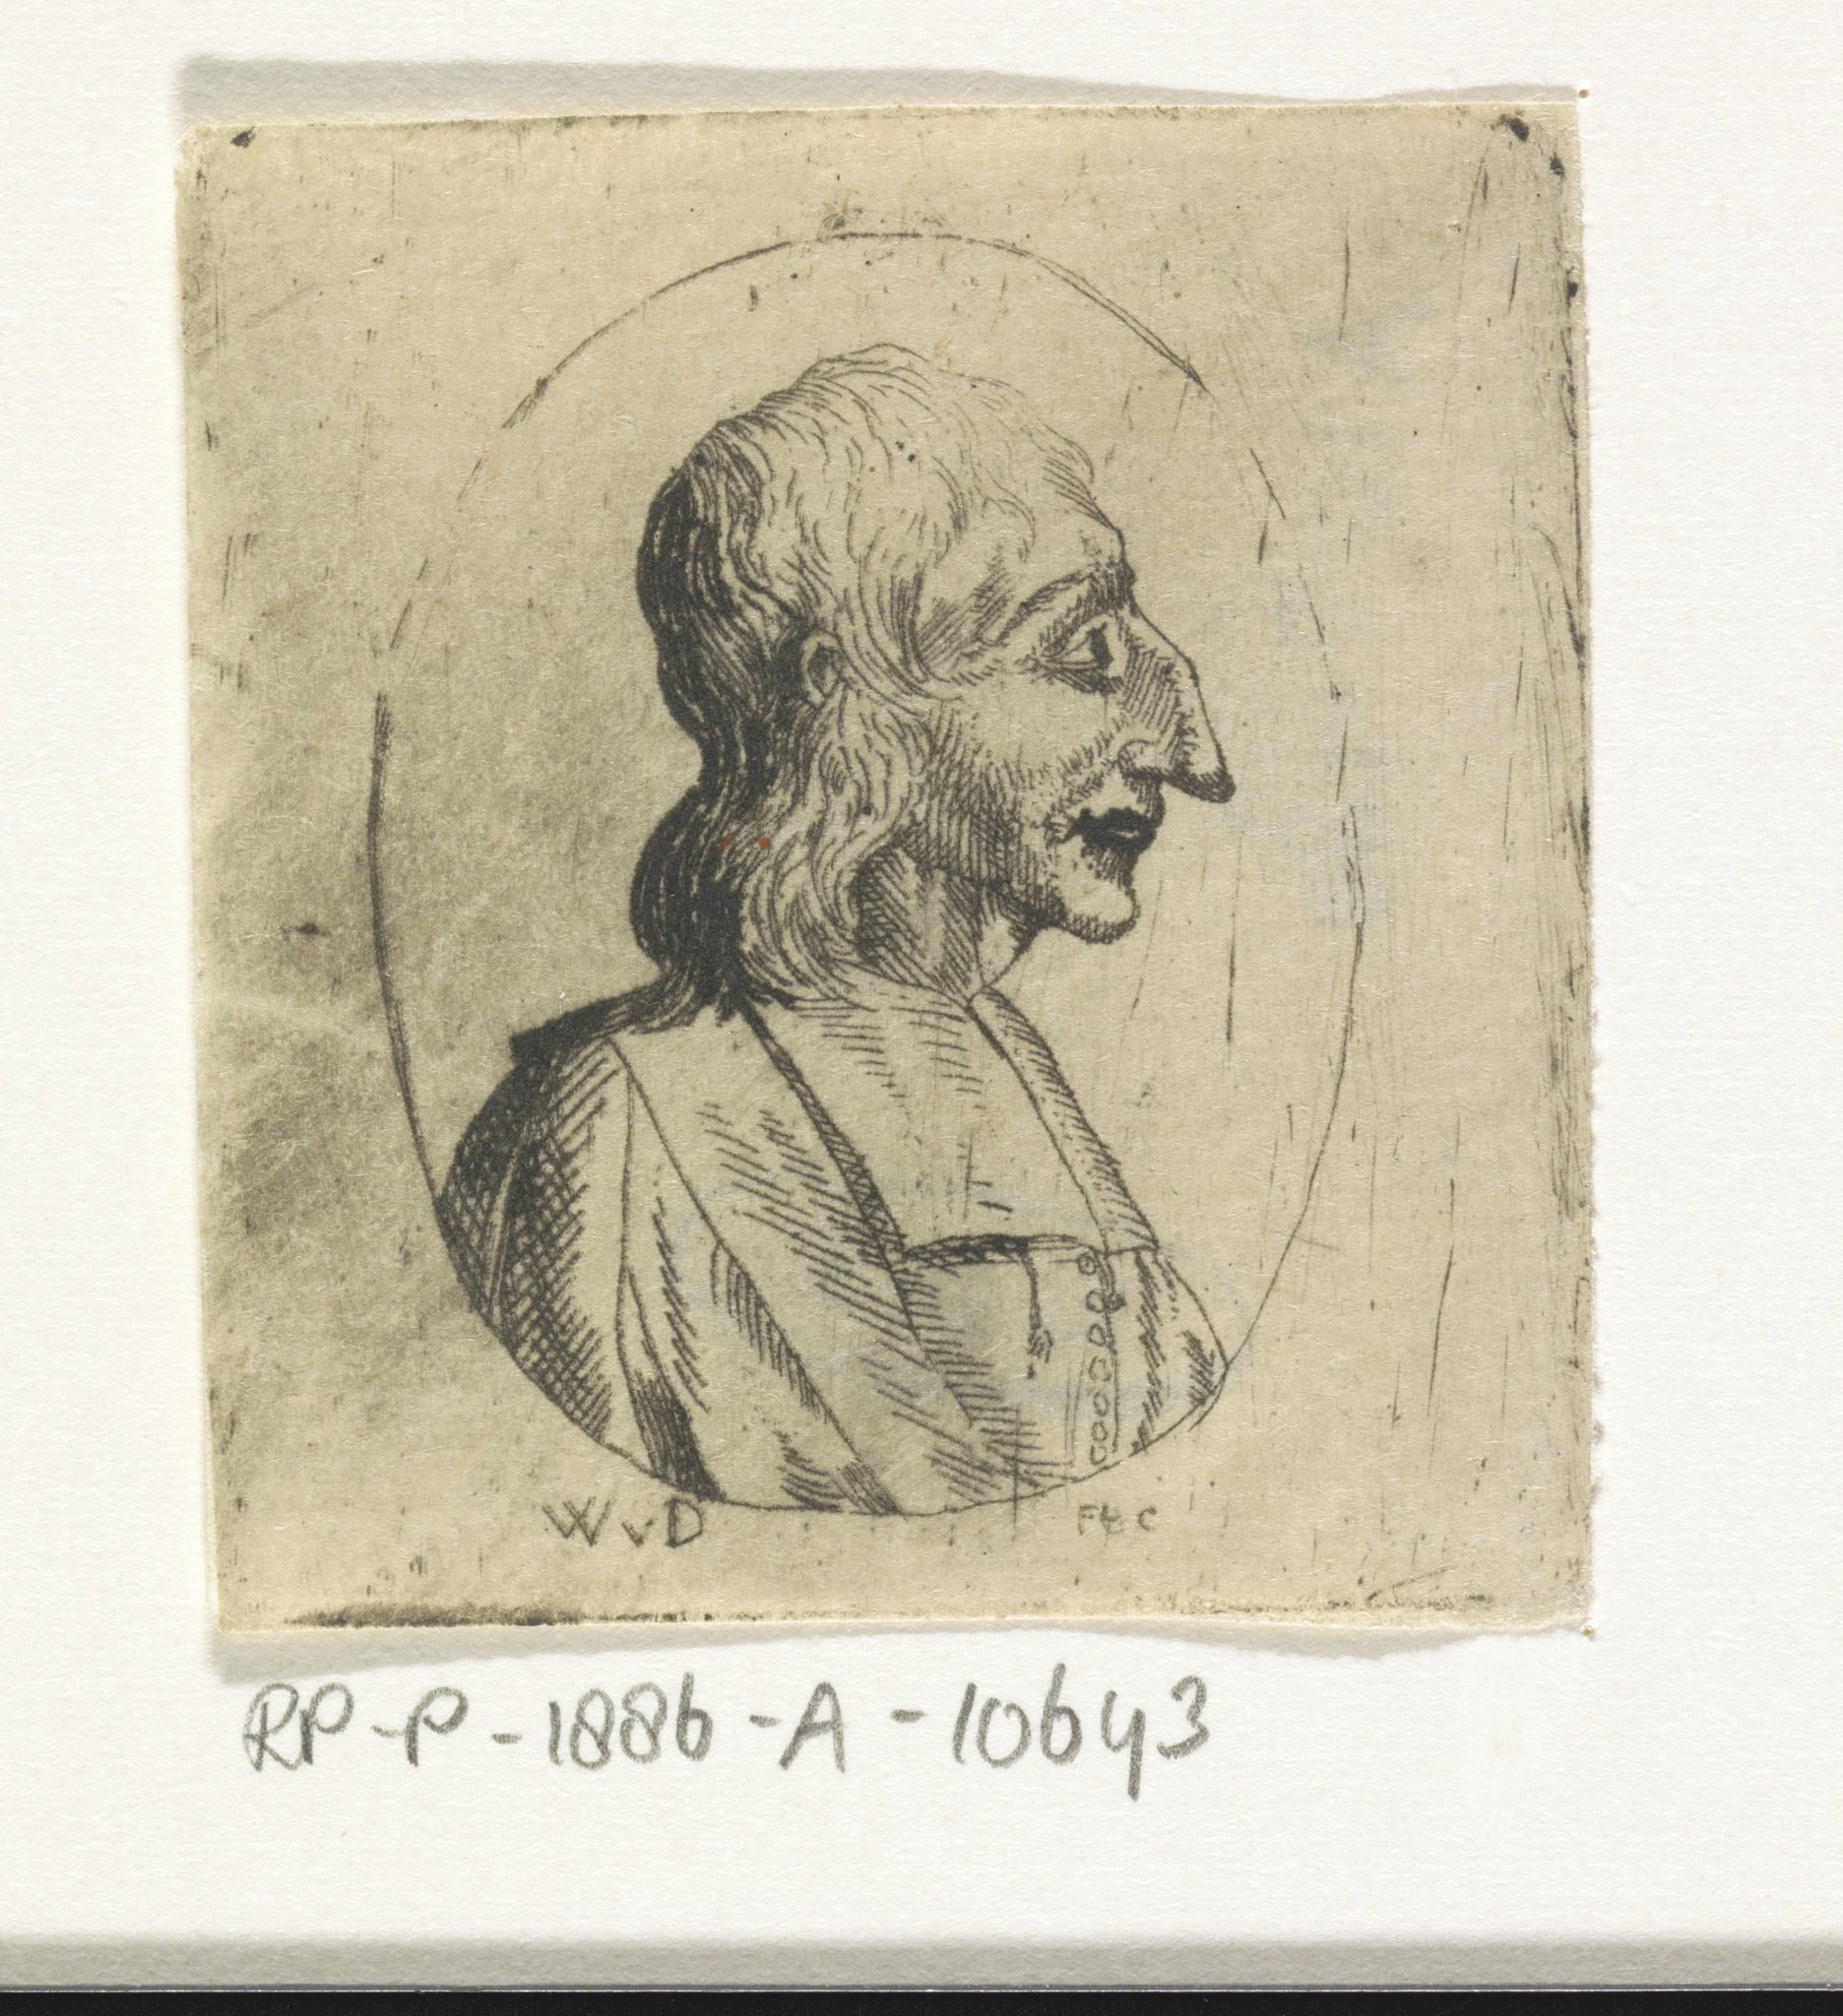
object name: print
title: Portret van Balthasar Bekker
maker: monogrammist wvd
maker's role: print maker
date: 1654-1698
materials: paper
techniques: etching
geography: netherlands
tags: balthasar bekker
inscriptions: collector's mark: Lugt 2228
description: Portret van Balthasar Bekker, predikant en letterkundige te Amsterdam. Later werd hij als predikant afgezet door de synode van Alkmaar.